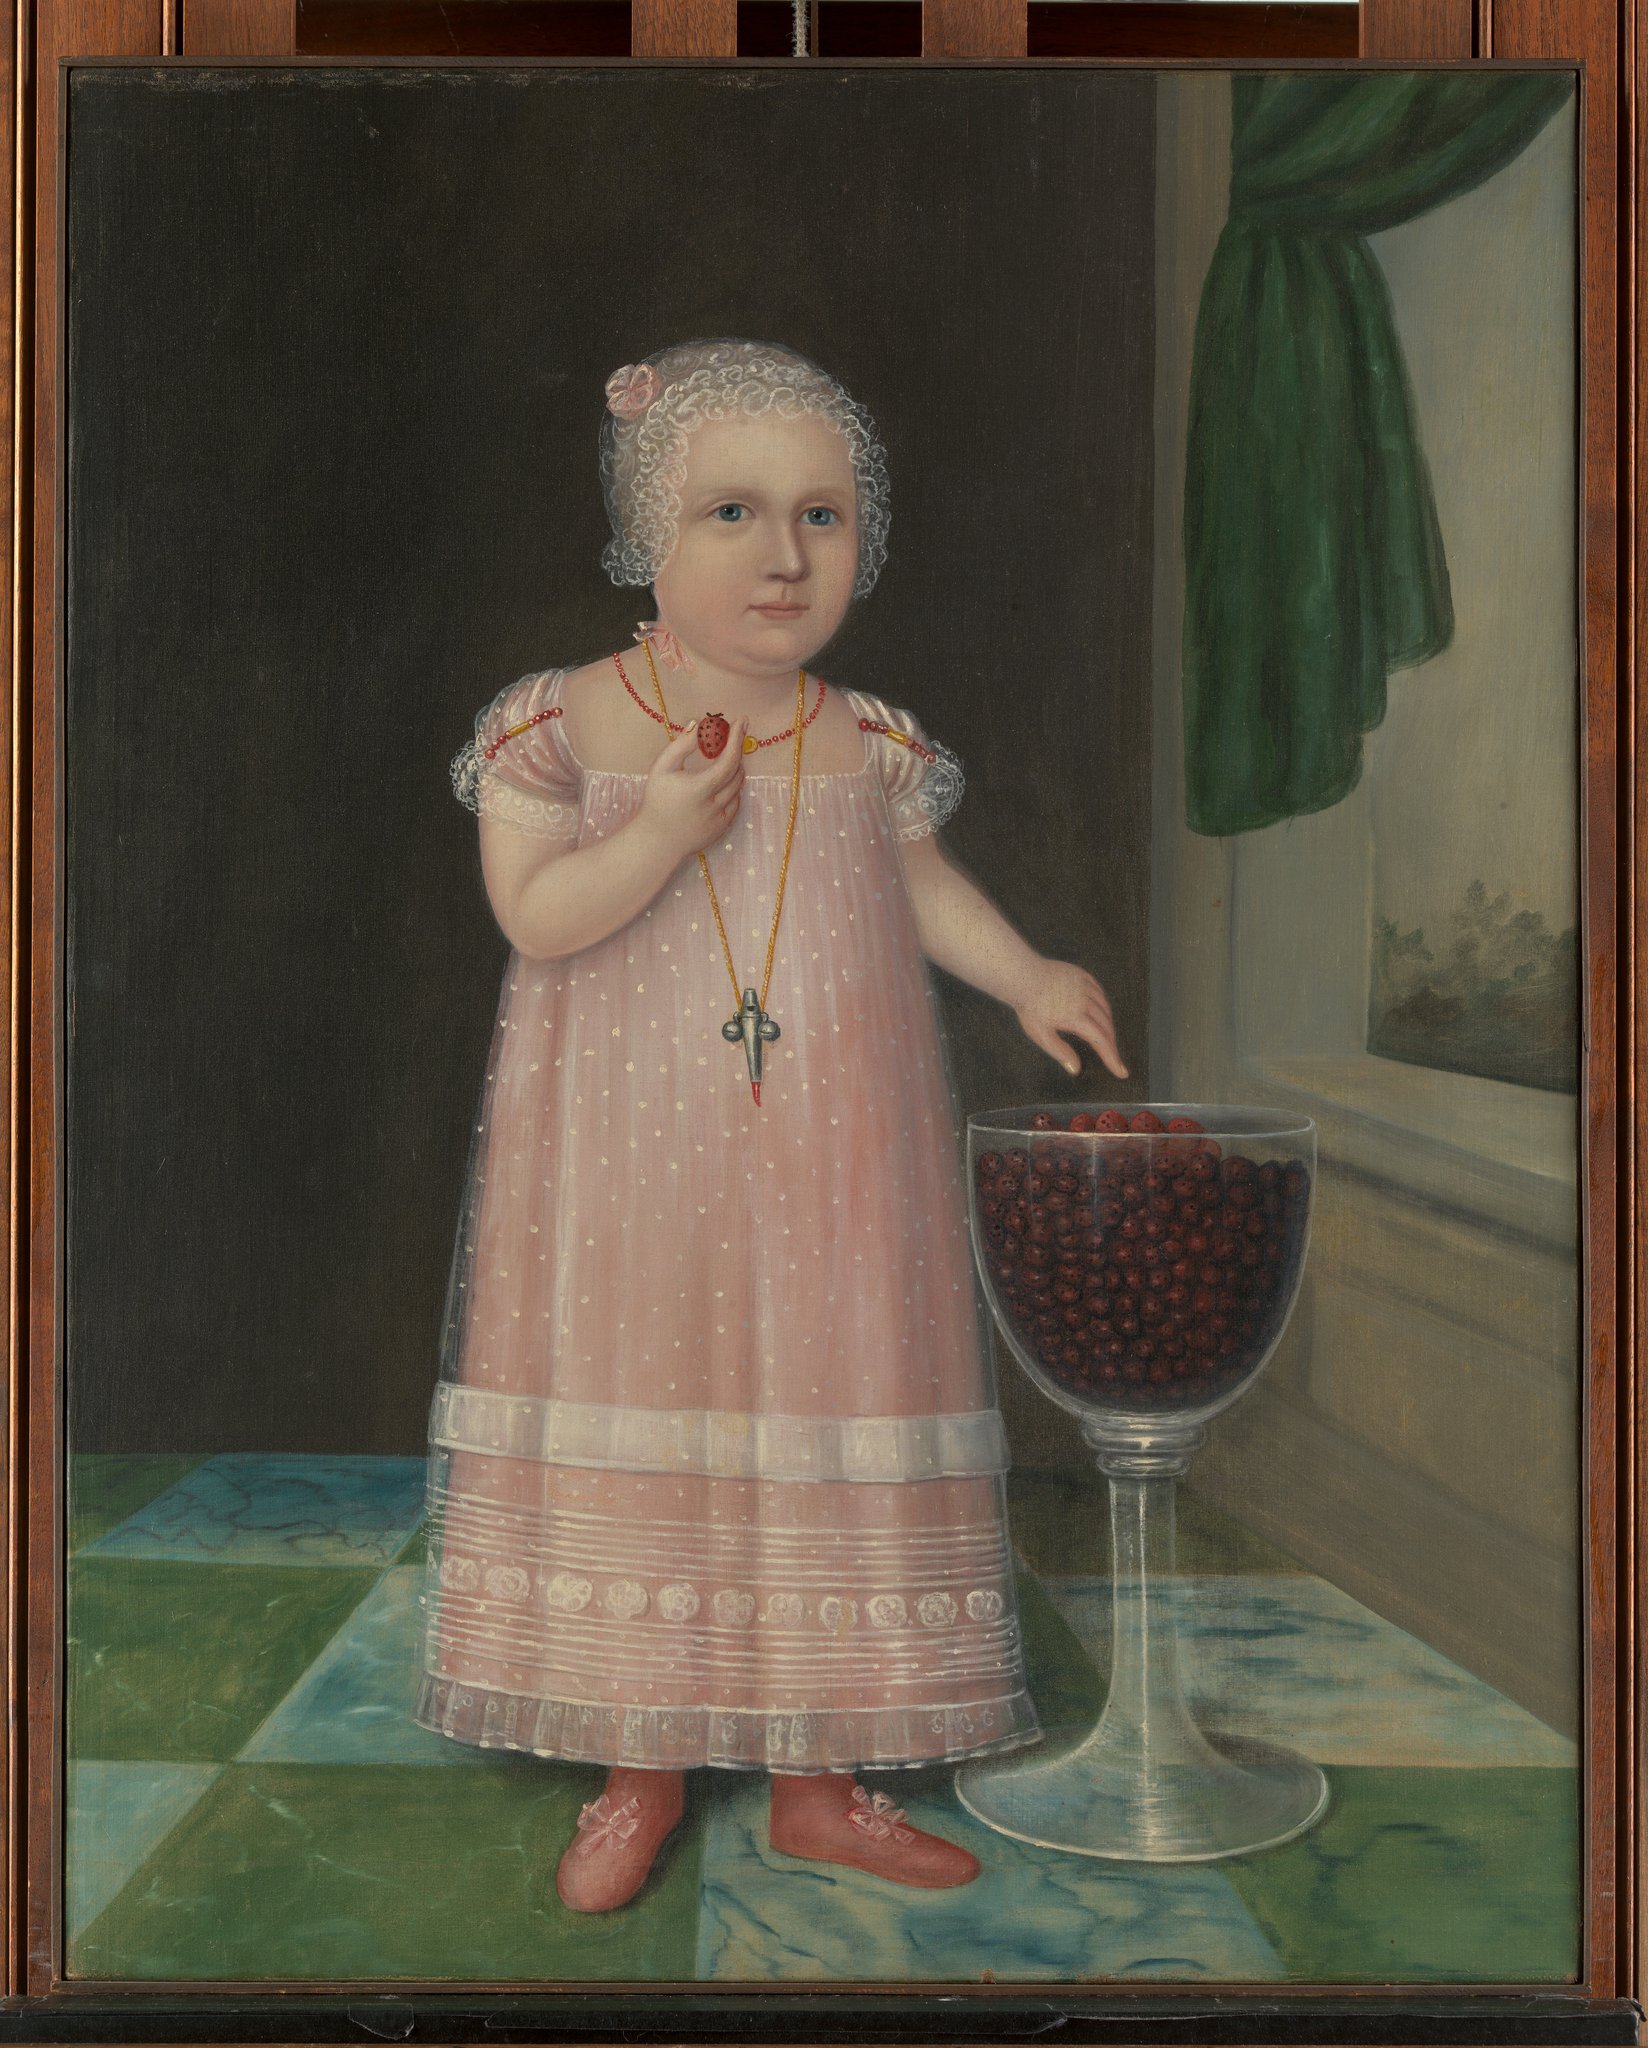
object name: painting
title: Emma Van Name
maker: joshua johnson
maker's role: artist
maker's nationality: american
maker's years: 1758-1829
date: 1805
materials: oil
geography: united states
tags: strawberries,girls,portraits,goblets